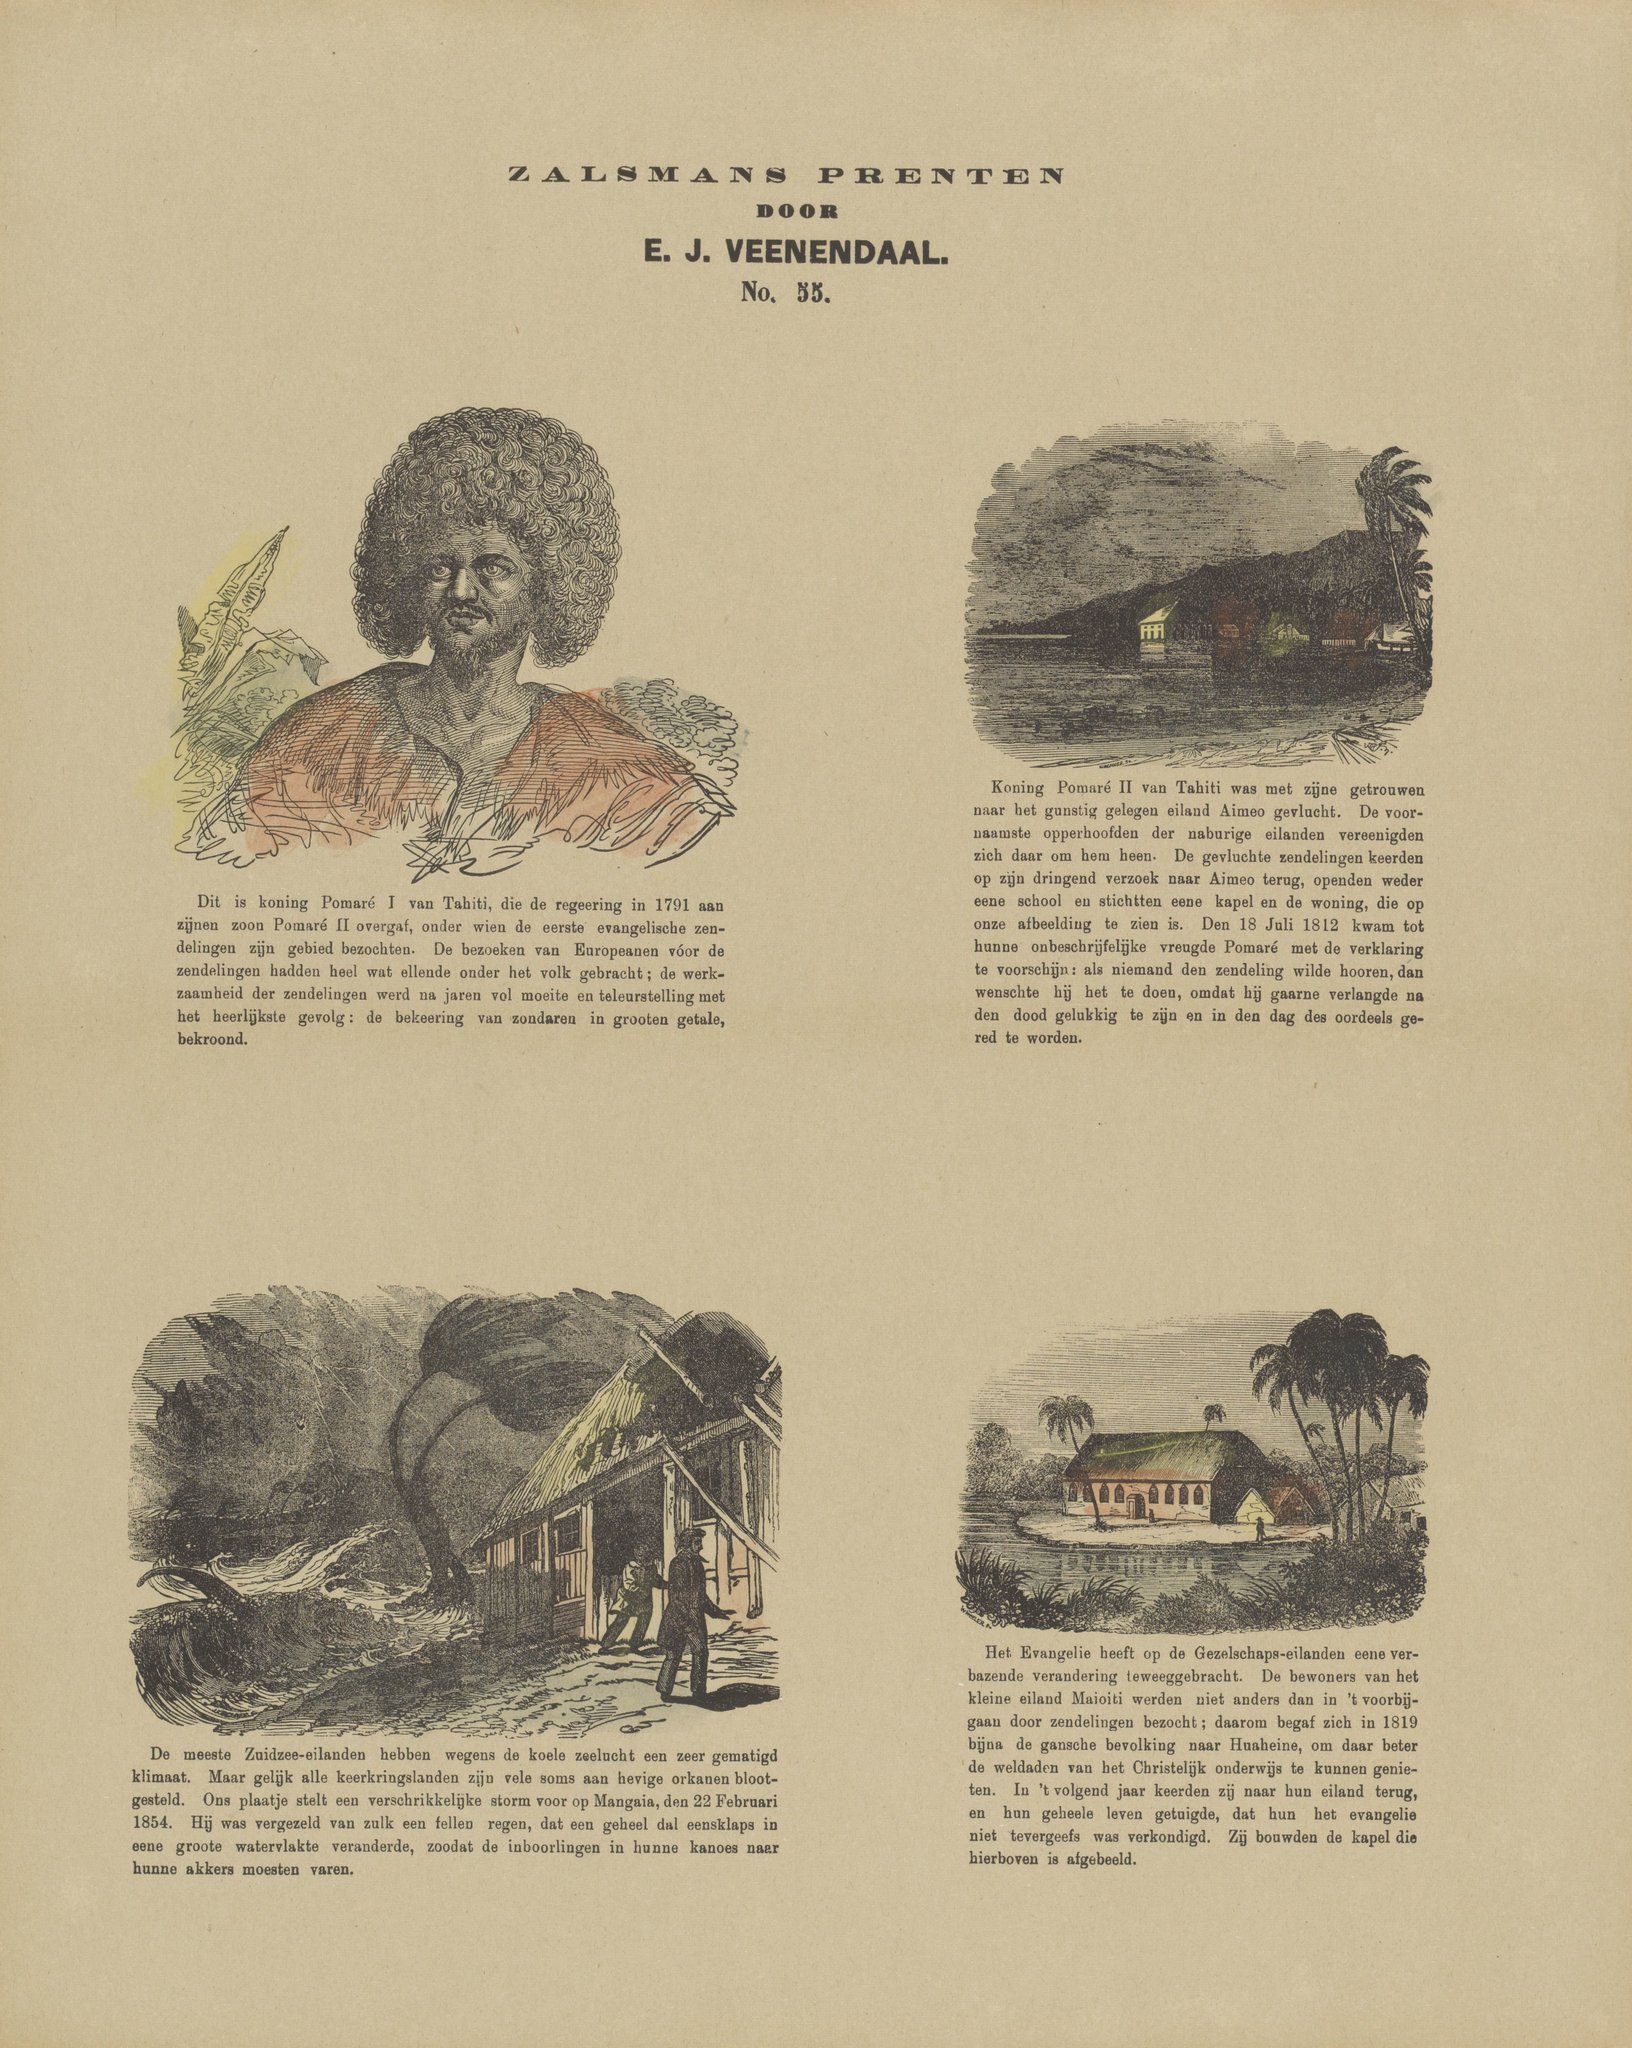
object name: popular print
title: Cookeilanden en bewoners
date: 1869-1882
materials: paper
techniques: colour, letterpress printing, engraving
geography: netherlands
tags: storm at sea, human races; peoples; nationalities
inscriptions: collector's mark: Lugt 2760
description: Blad met 4 voorstellingen van een bewoner, woningen en religieuze beelden van de Sandwicheilanden. Onder elke afbeelding een onderschrift. Genummerd midden boven: No. 55.